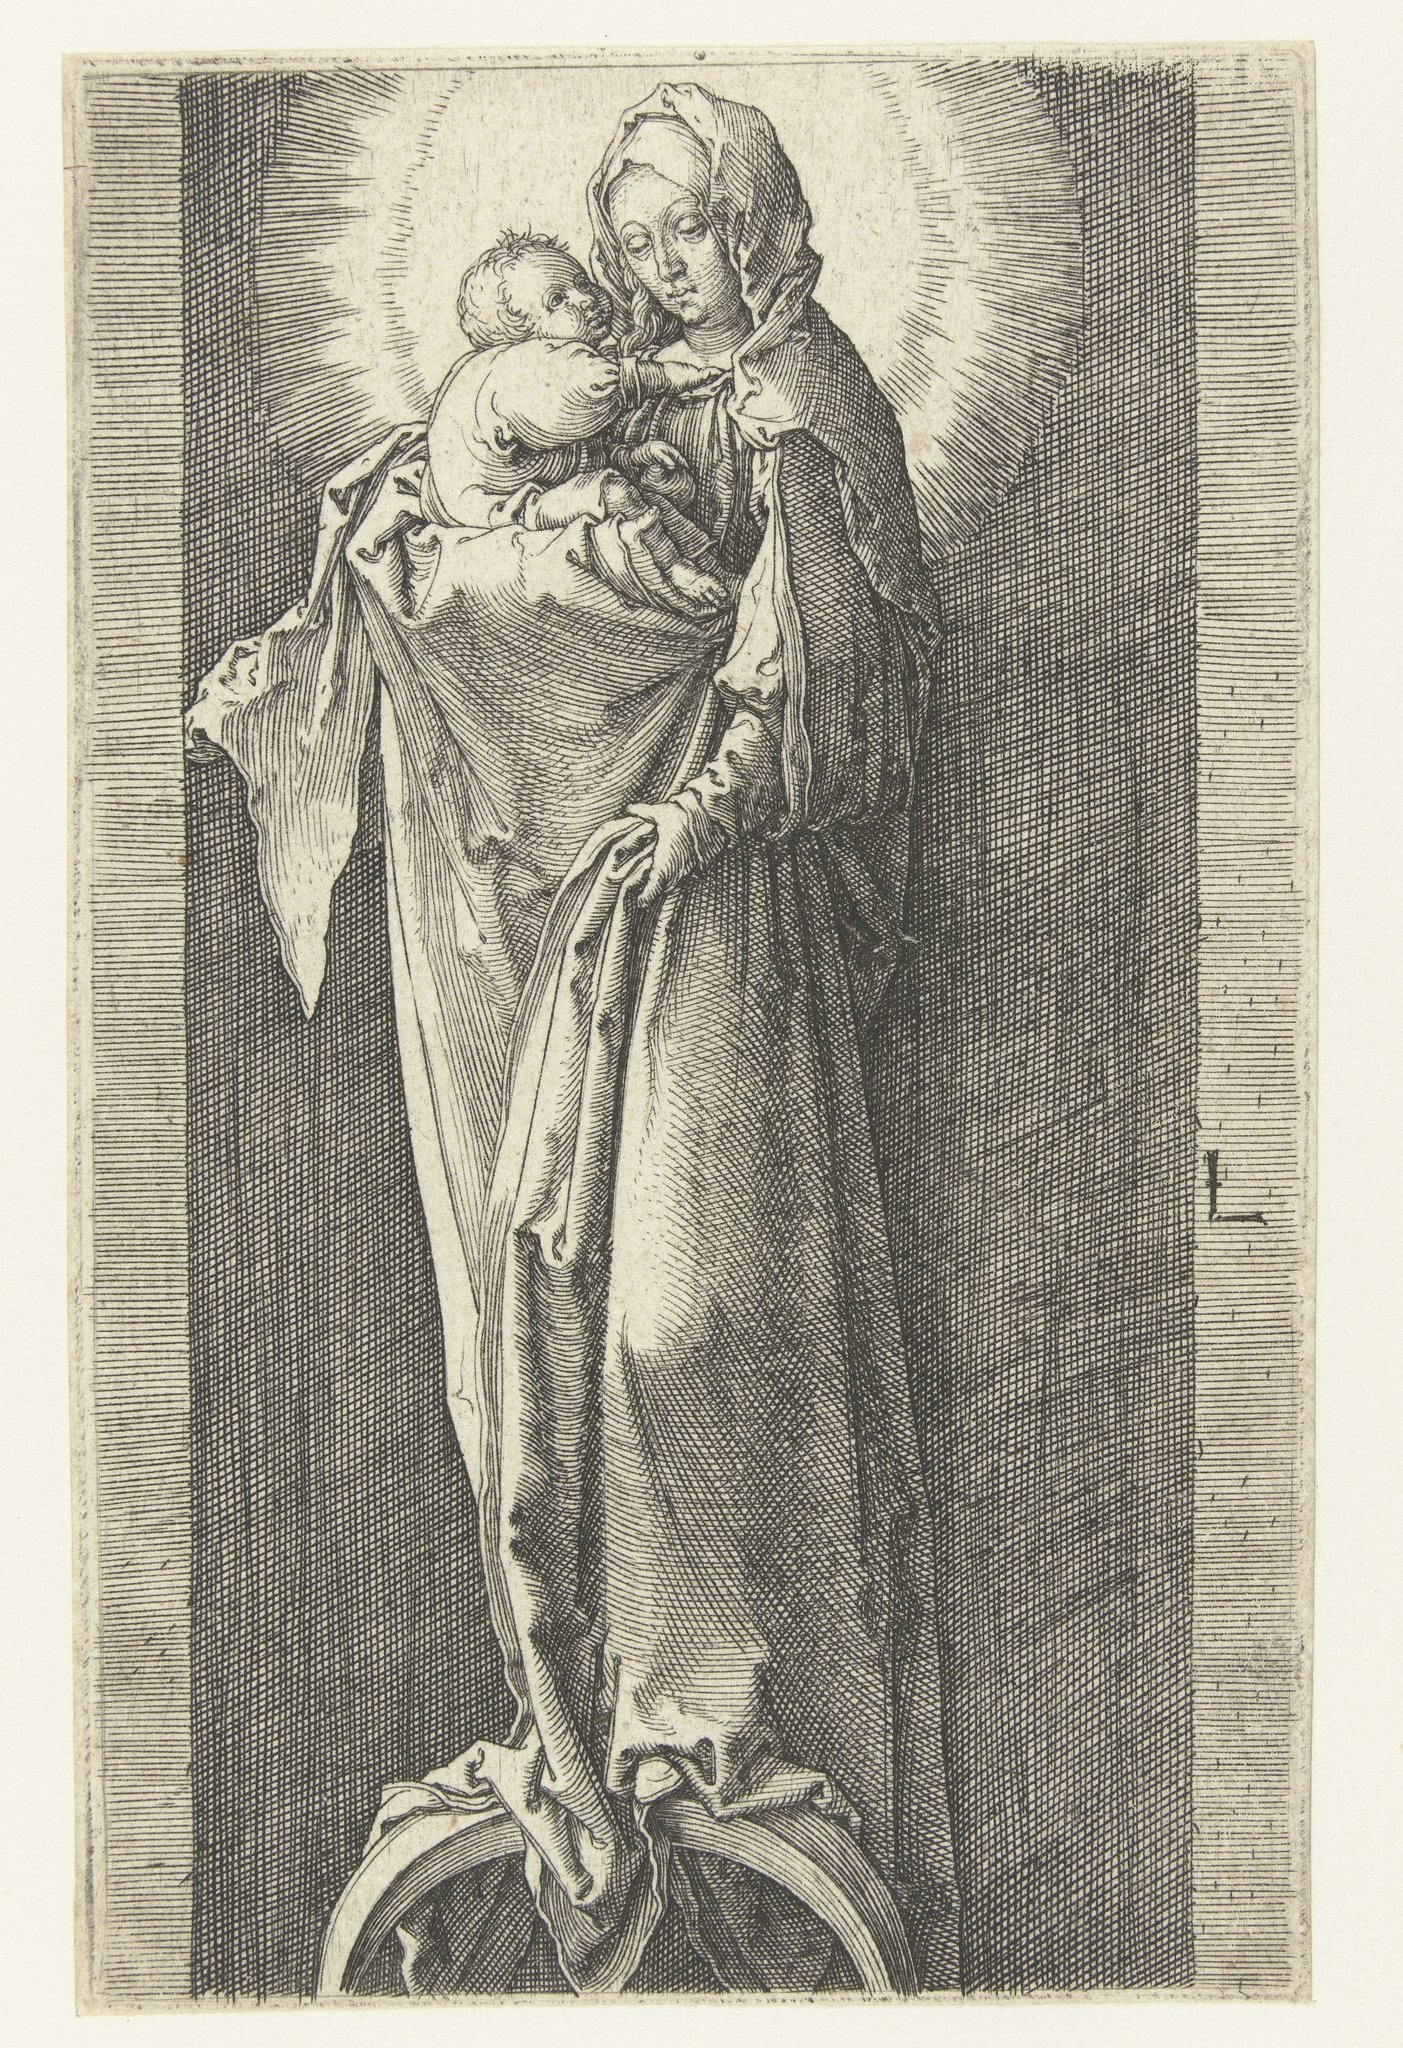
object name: print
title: Maria met kind in een nis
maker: lucas van leyden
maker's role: draughtsman, painter, print maker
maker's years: 1494-1533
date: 1516-1520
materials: paper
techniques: engraving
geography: low countries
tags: 'immaculata', 'purisima': mary, usually standing on a crescent moon, descending from heaven, exempt from original sin (sometimes trampling serpent)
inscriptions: collector's mark: Lugt 240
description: Maria met kind staand op maansikkel in nis.